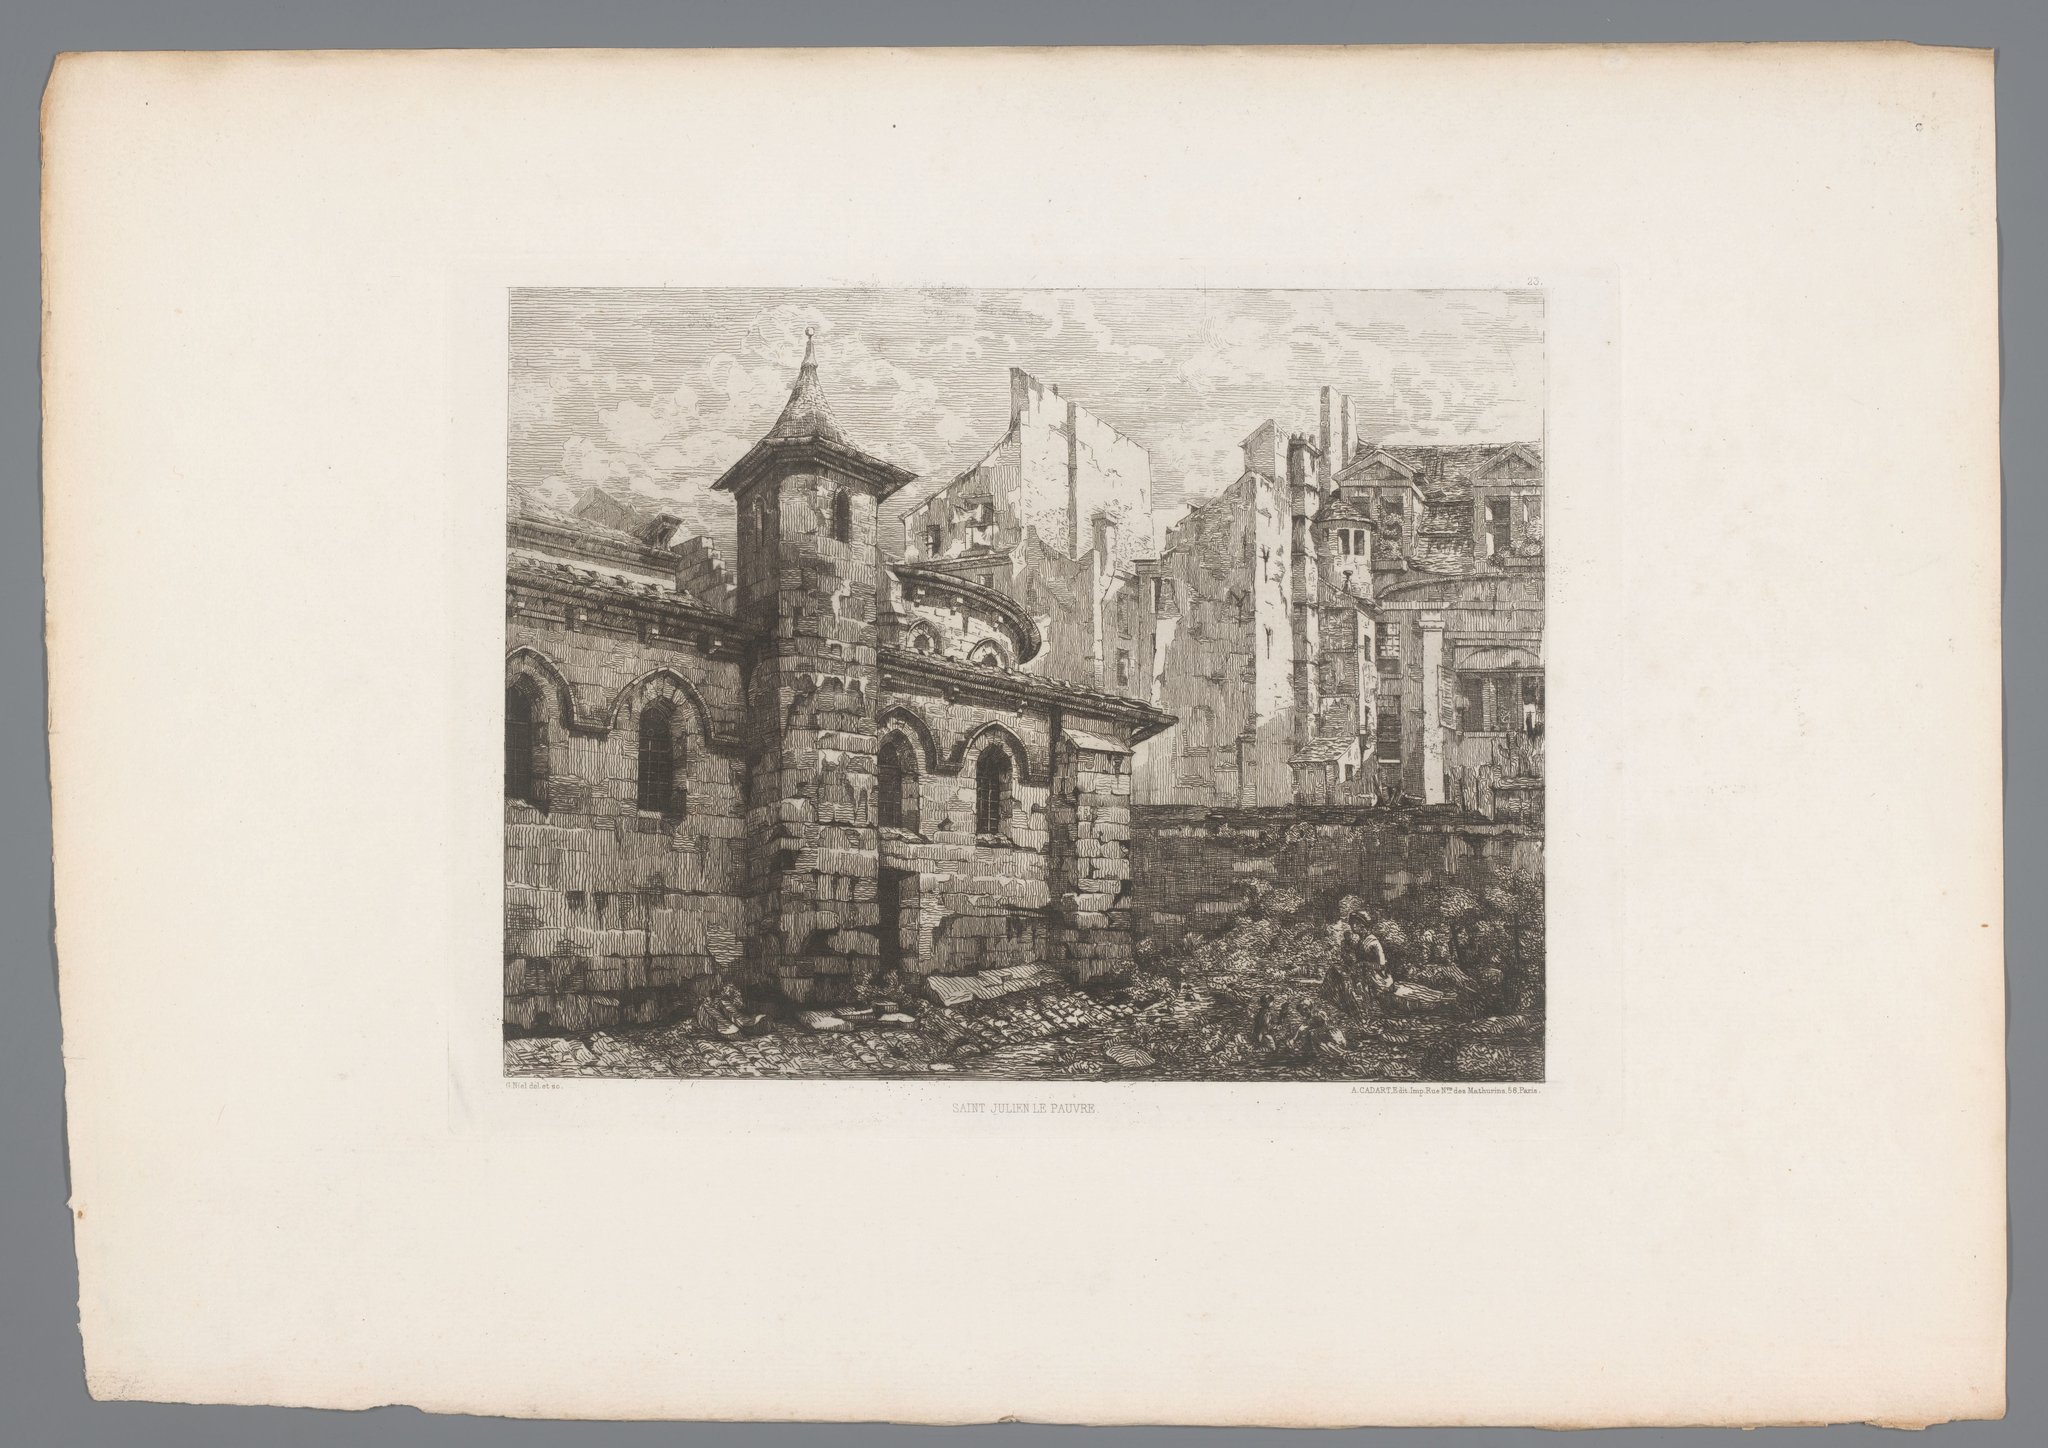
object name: print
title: Gezicht op Saint-Julien-le-Pauvre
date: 1874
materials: paper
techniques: drypoint, etching, intaglio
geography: paris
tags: church (exterior)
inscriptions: collector's mark: Lugt 2228, collector's mark: ‘AFE v S’, collector's mark: Lugt 2760